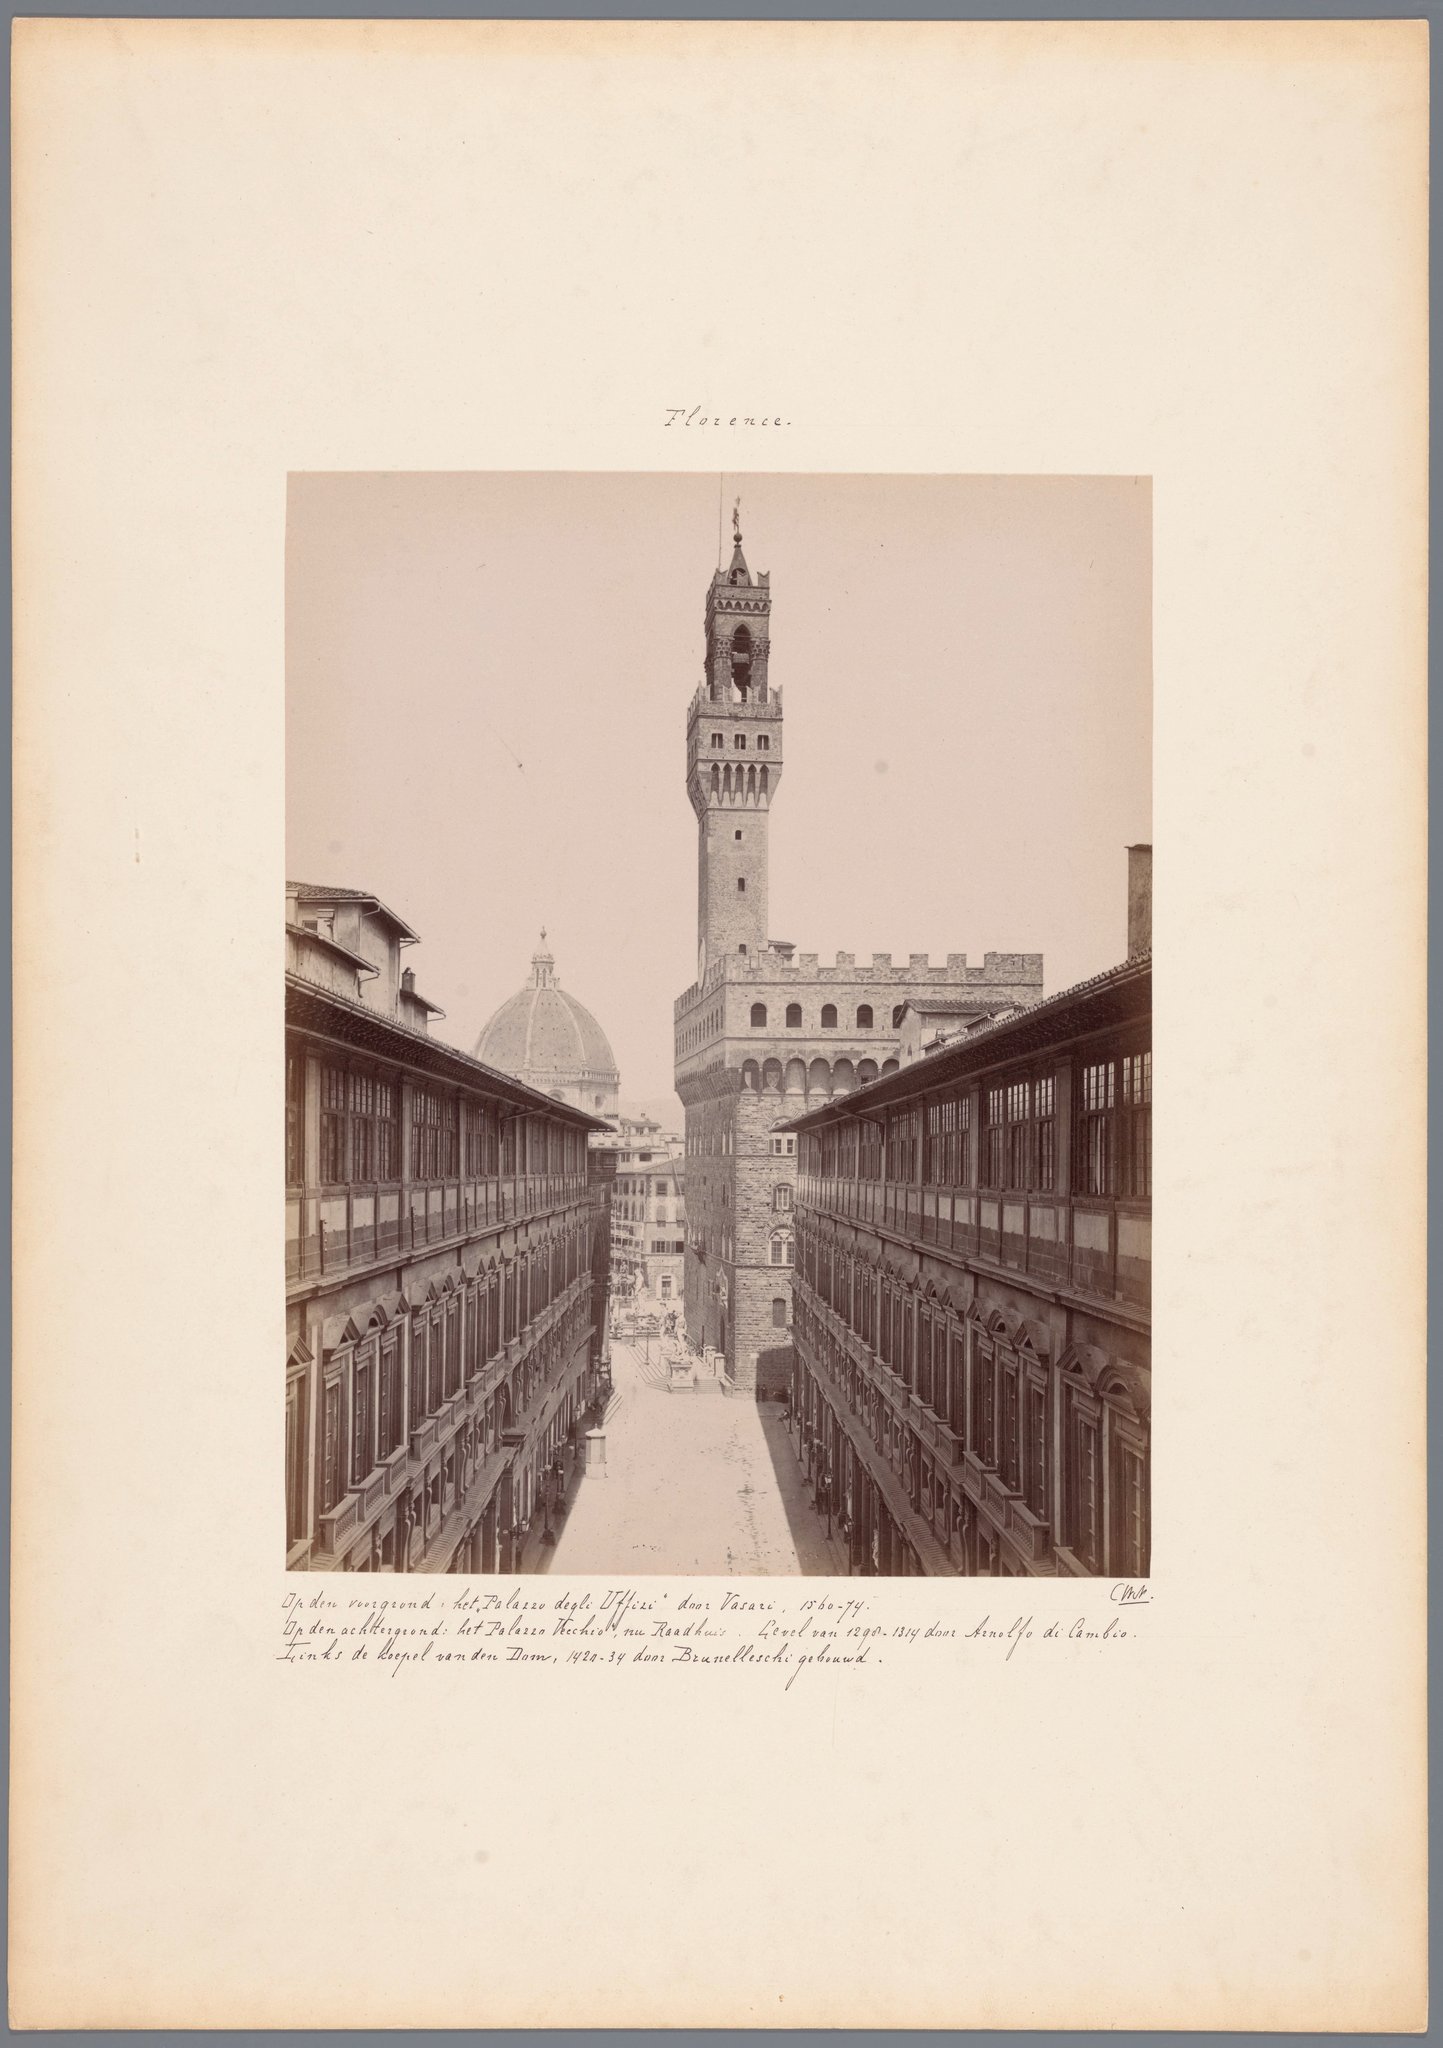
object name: photograph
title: Gezicht op het Palazzo Vecchio te Florence, met op de voorgrond de Uffizi en op de achtergrond de koepel van de Dom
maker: Anonymous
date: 1875-1900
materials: cardboard, photographic support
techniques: albumen print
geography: florence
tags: tower, clock tower ~ monumental adornment, palace, dome ~ architecture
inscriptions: inscription: ‘Florence.’, collector's mark: ‘KUNSTNIJVERHEIDSCHOOL QUELLINUS AMSTERDAM FRANS HALSSTRAAT 14.’, inscription: ‘CWN.’, collector's mark: ‘INSTITUUT VOOR KUNST-NIJVERHEIDSONDERWIJS GABRIËL METSUSTRAAT No. 16 AMSTERDAM’